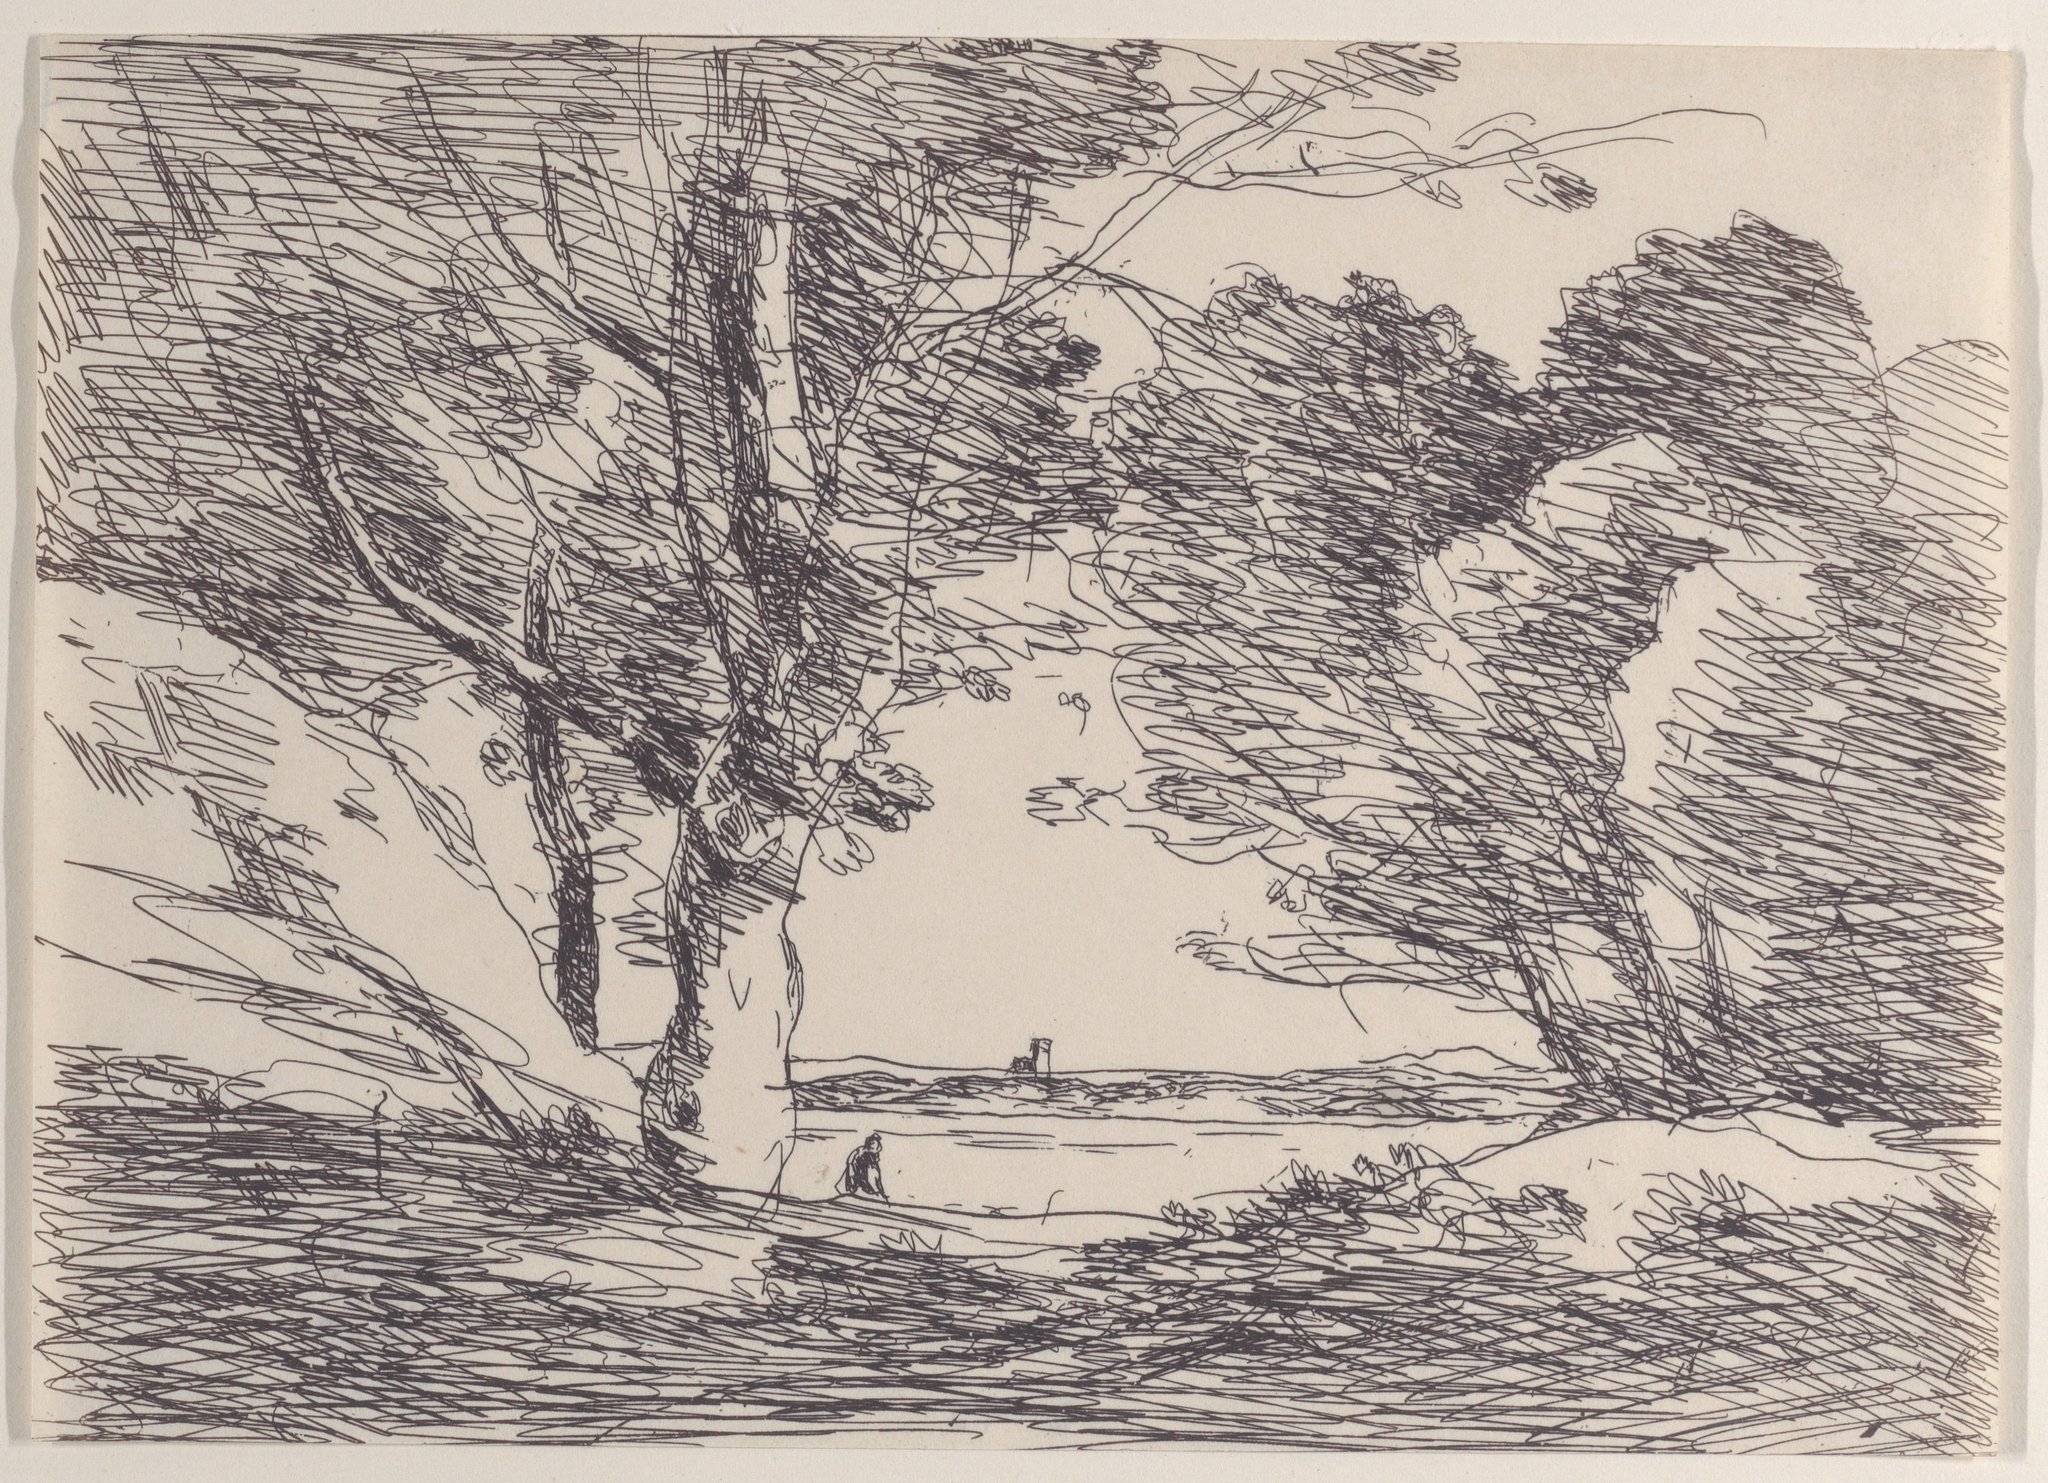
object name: print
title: Tower at the Lake's Horizon (Tour á L'Horizon d'un Lac)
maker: jean-baptiste-camille corot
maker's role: artist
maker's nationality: french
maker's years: 1796-1875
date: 1871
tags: landscapes,trees